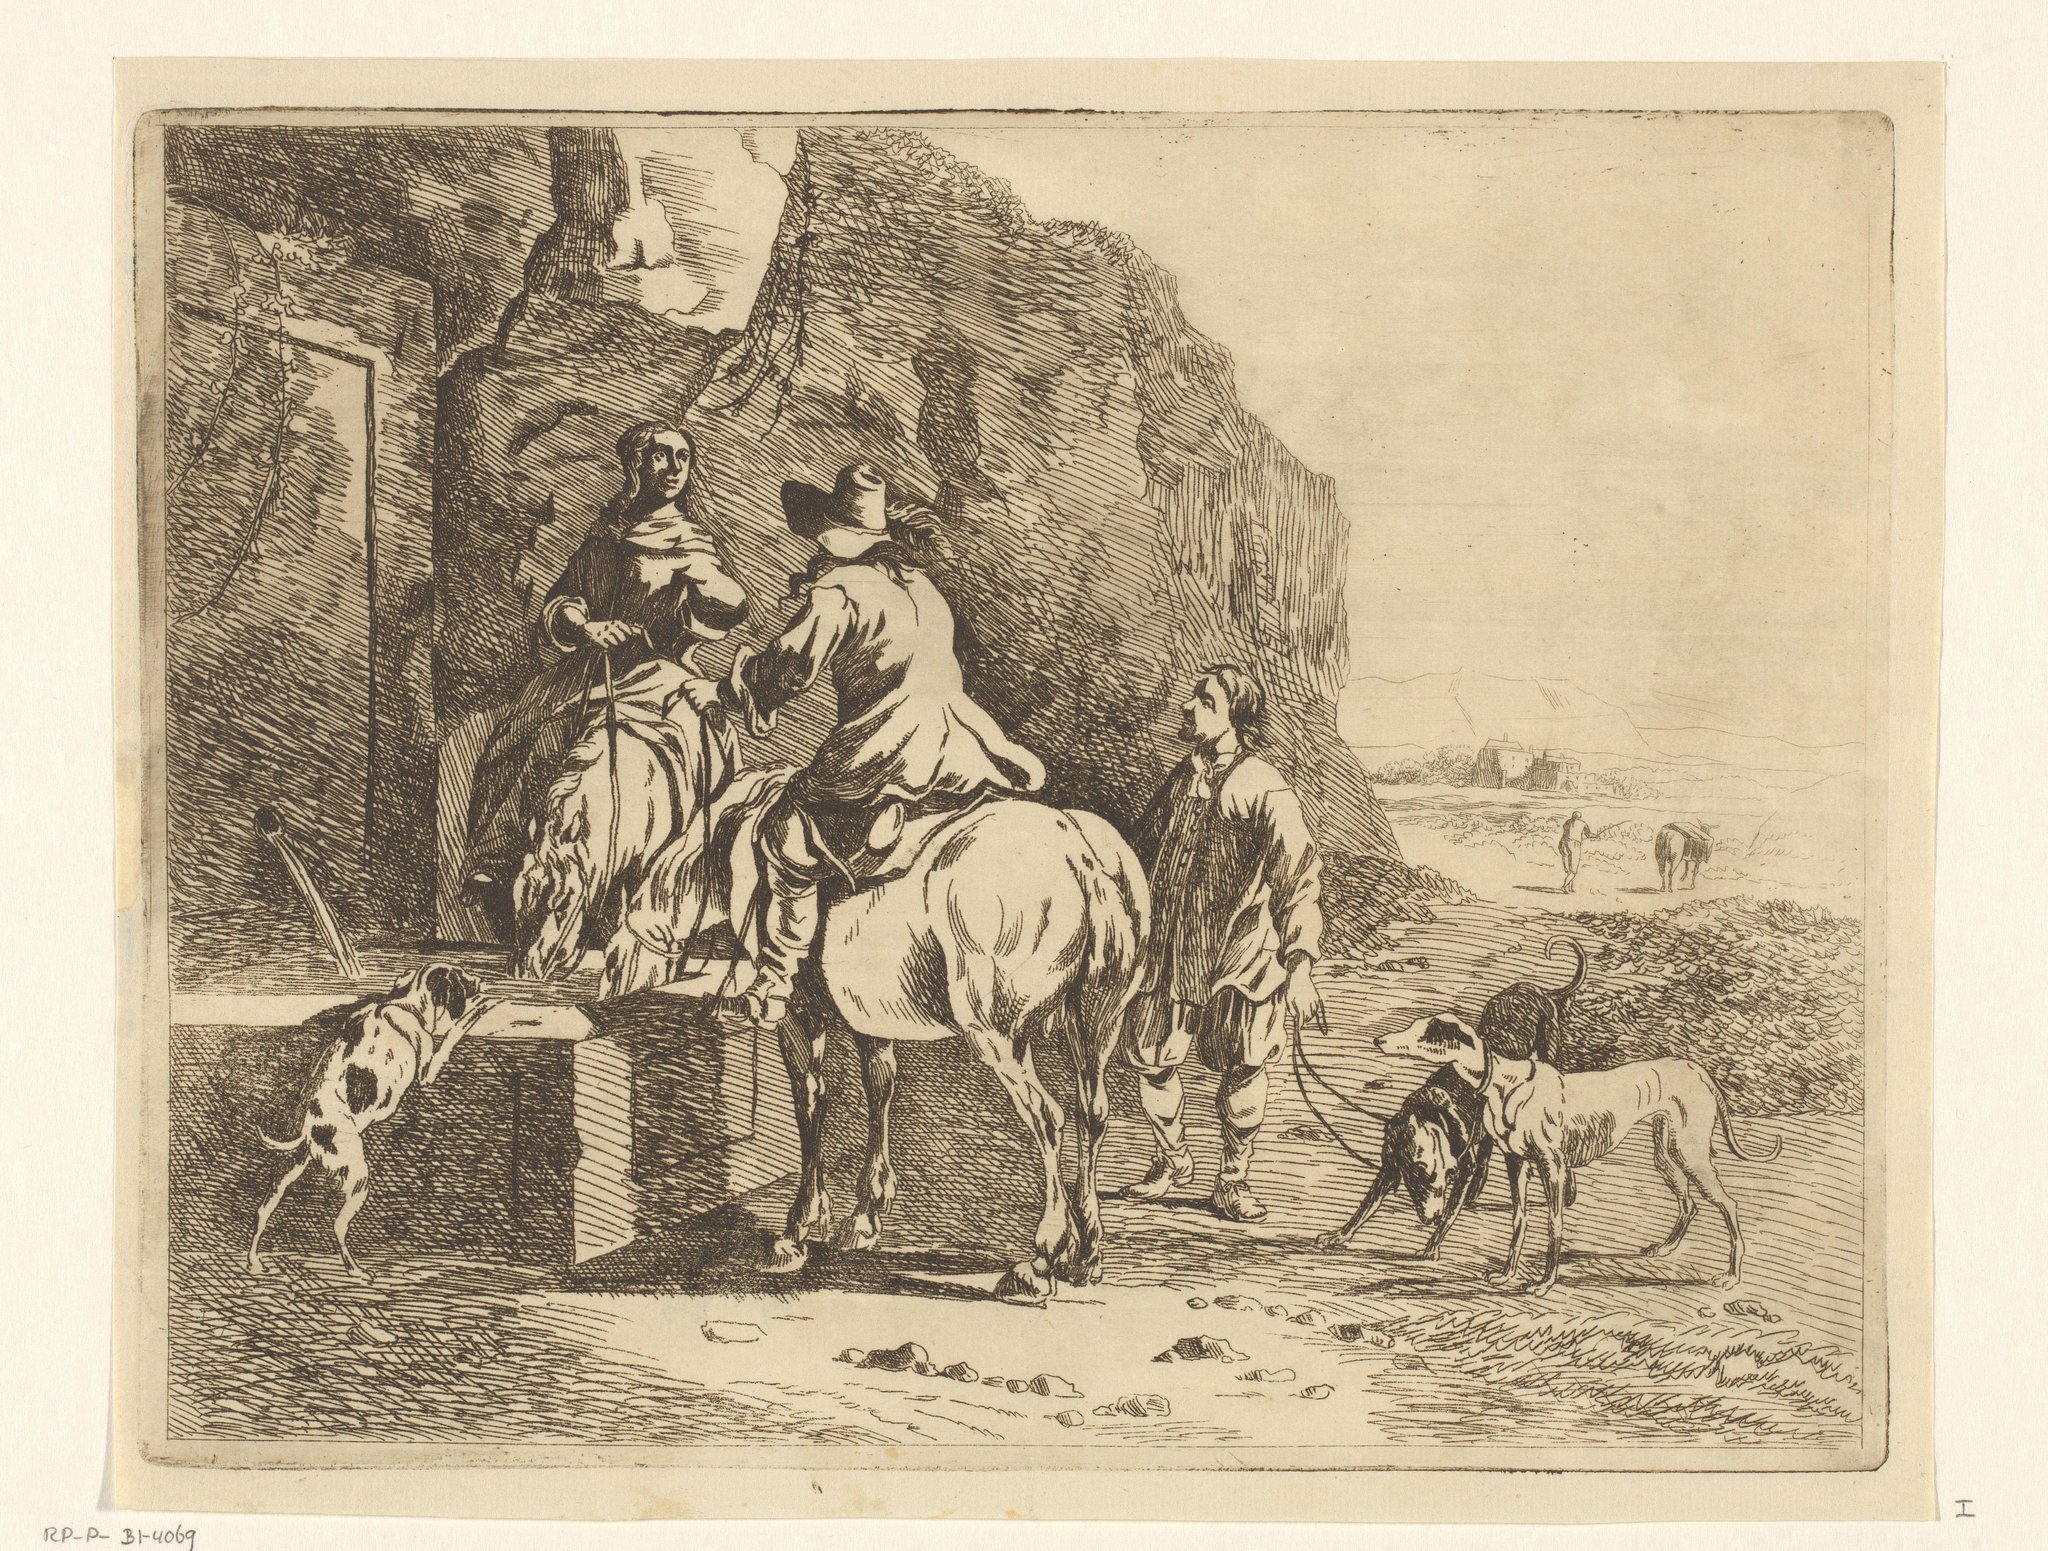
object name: print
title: Ruiters bij drinkplaats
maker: anthonie van den bos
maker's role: draughtsman, print maker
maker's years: 1763-1838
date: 1778-1838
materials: paper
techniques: etching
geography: netherlands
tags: man and animal (+ watering animal)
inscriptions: collector's mark: Lugt 2228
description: Een man en een vrouw laten hun paarden drinken bij een fontein in een rotsmuur. Ze maken een praatje met een man die zijn honden uitlaat.